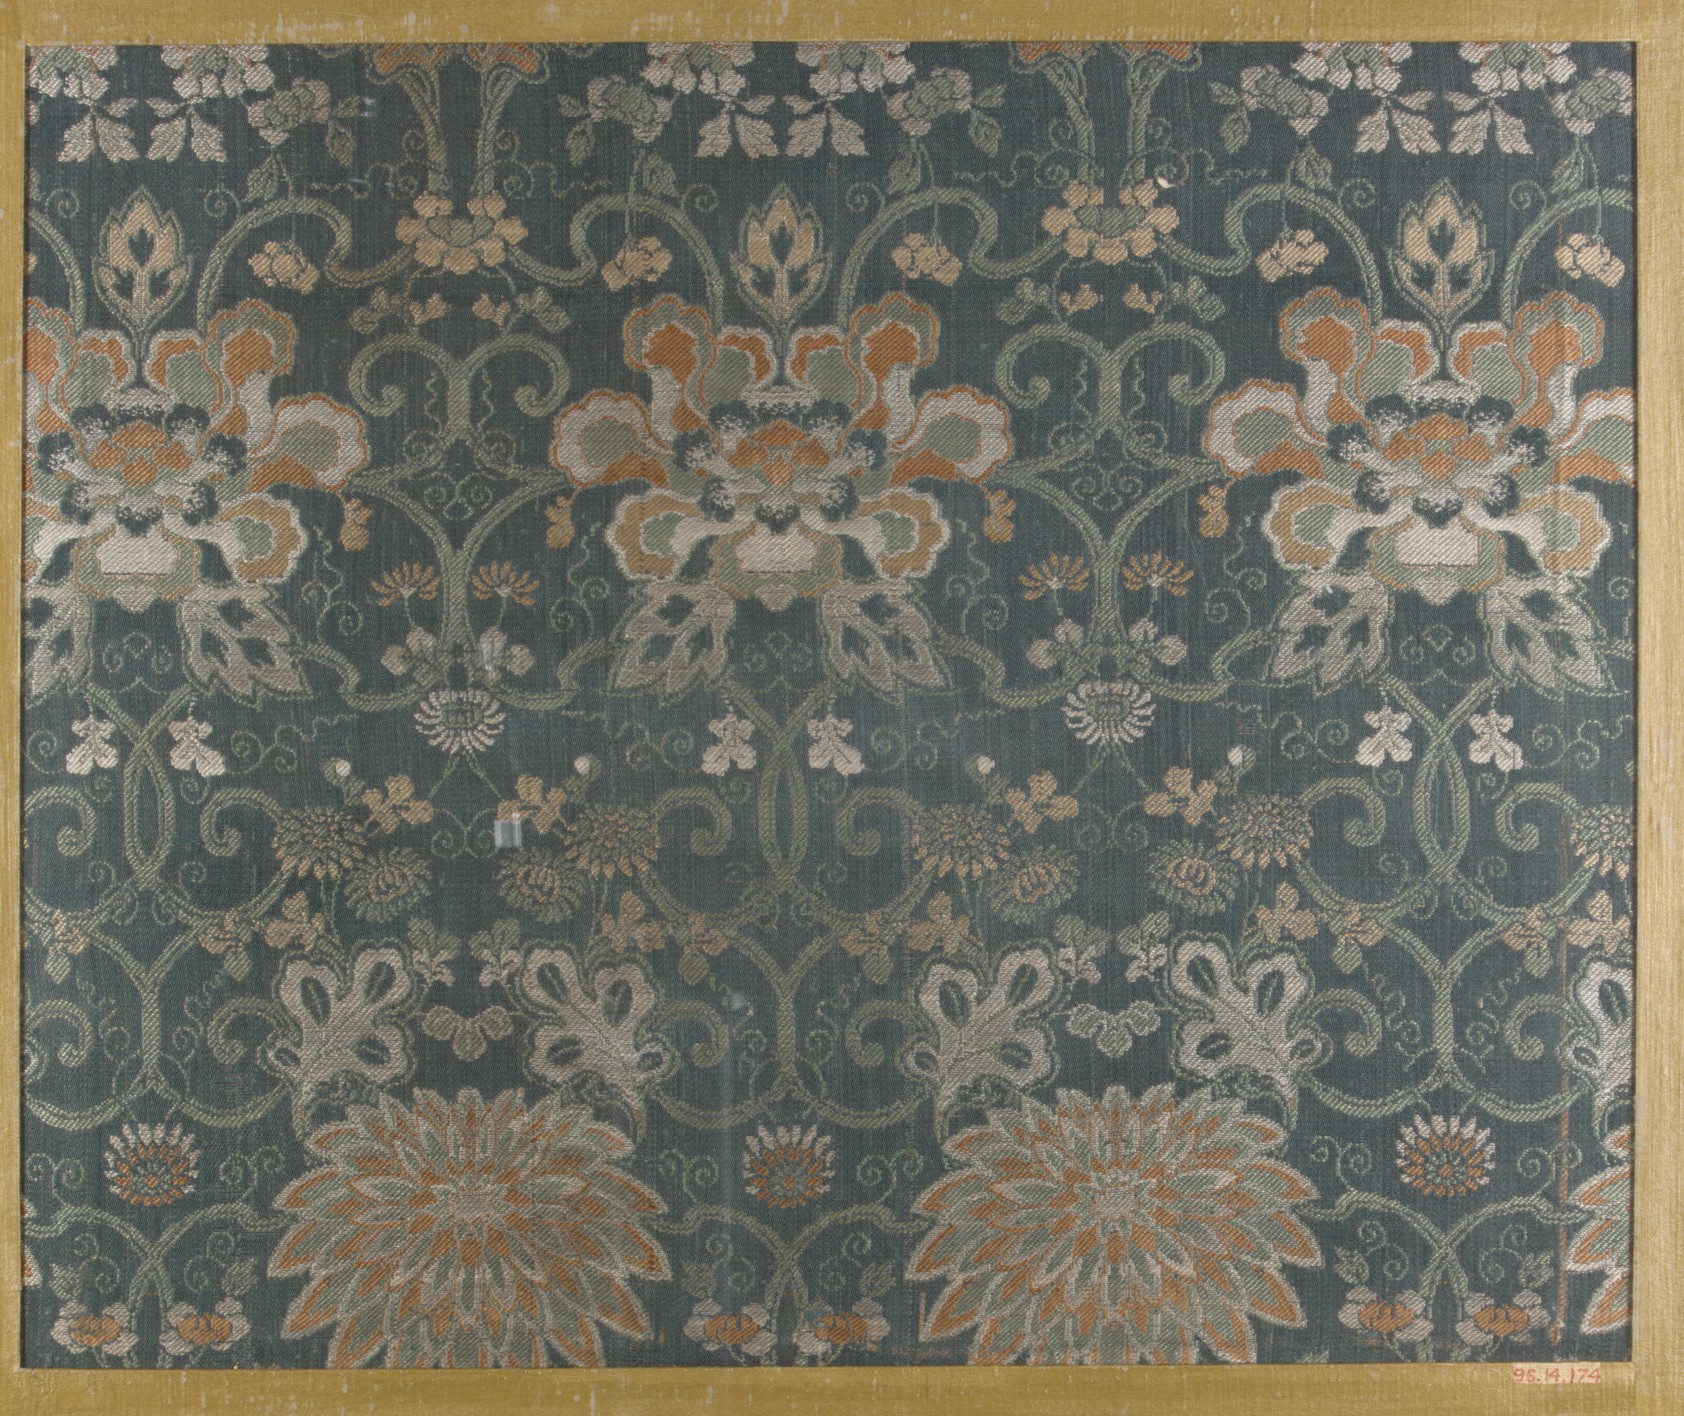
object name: fragment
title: Textile fragment with repeating pattern of chrysanthemums and peonies in floral arabesque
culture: japanese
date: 1701-1900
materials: silk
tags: peonies